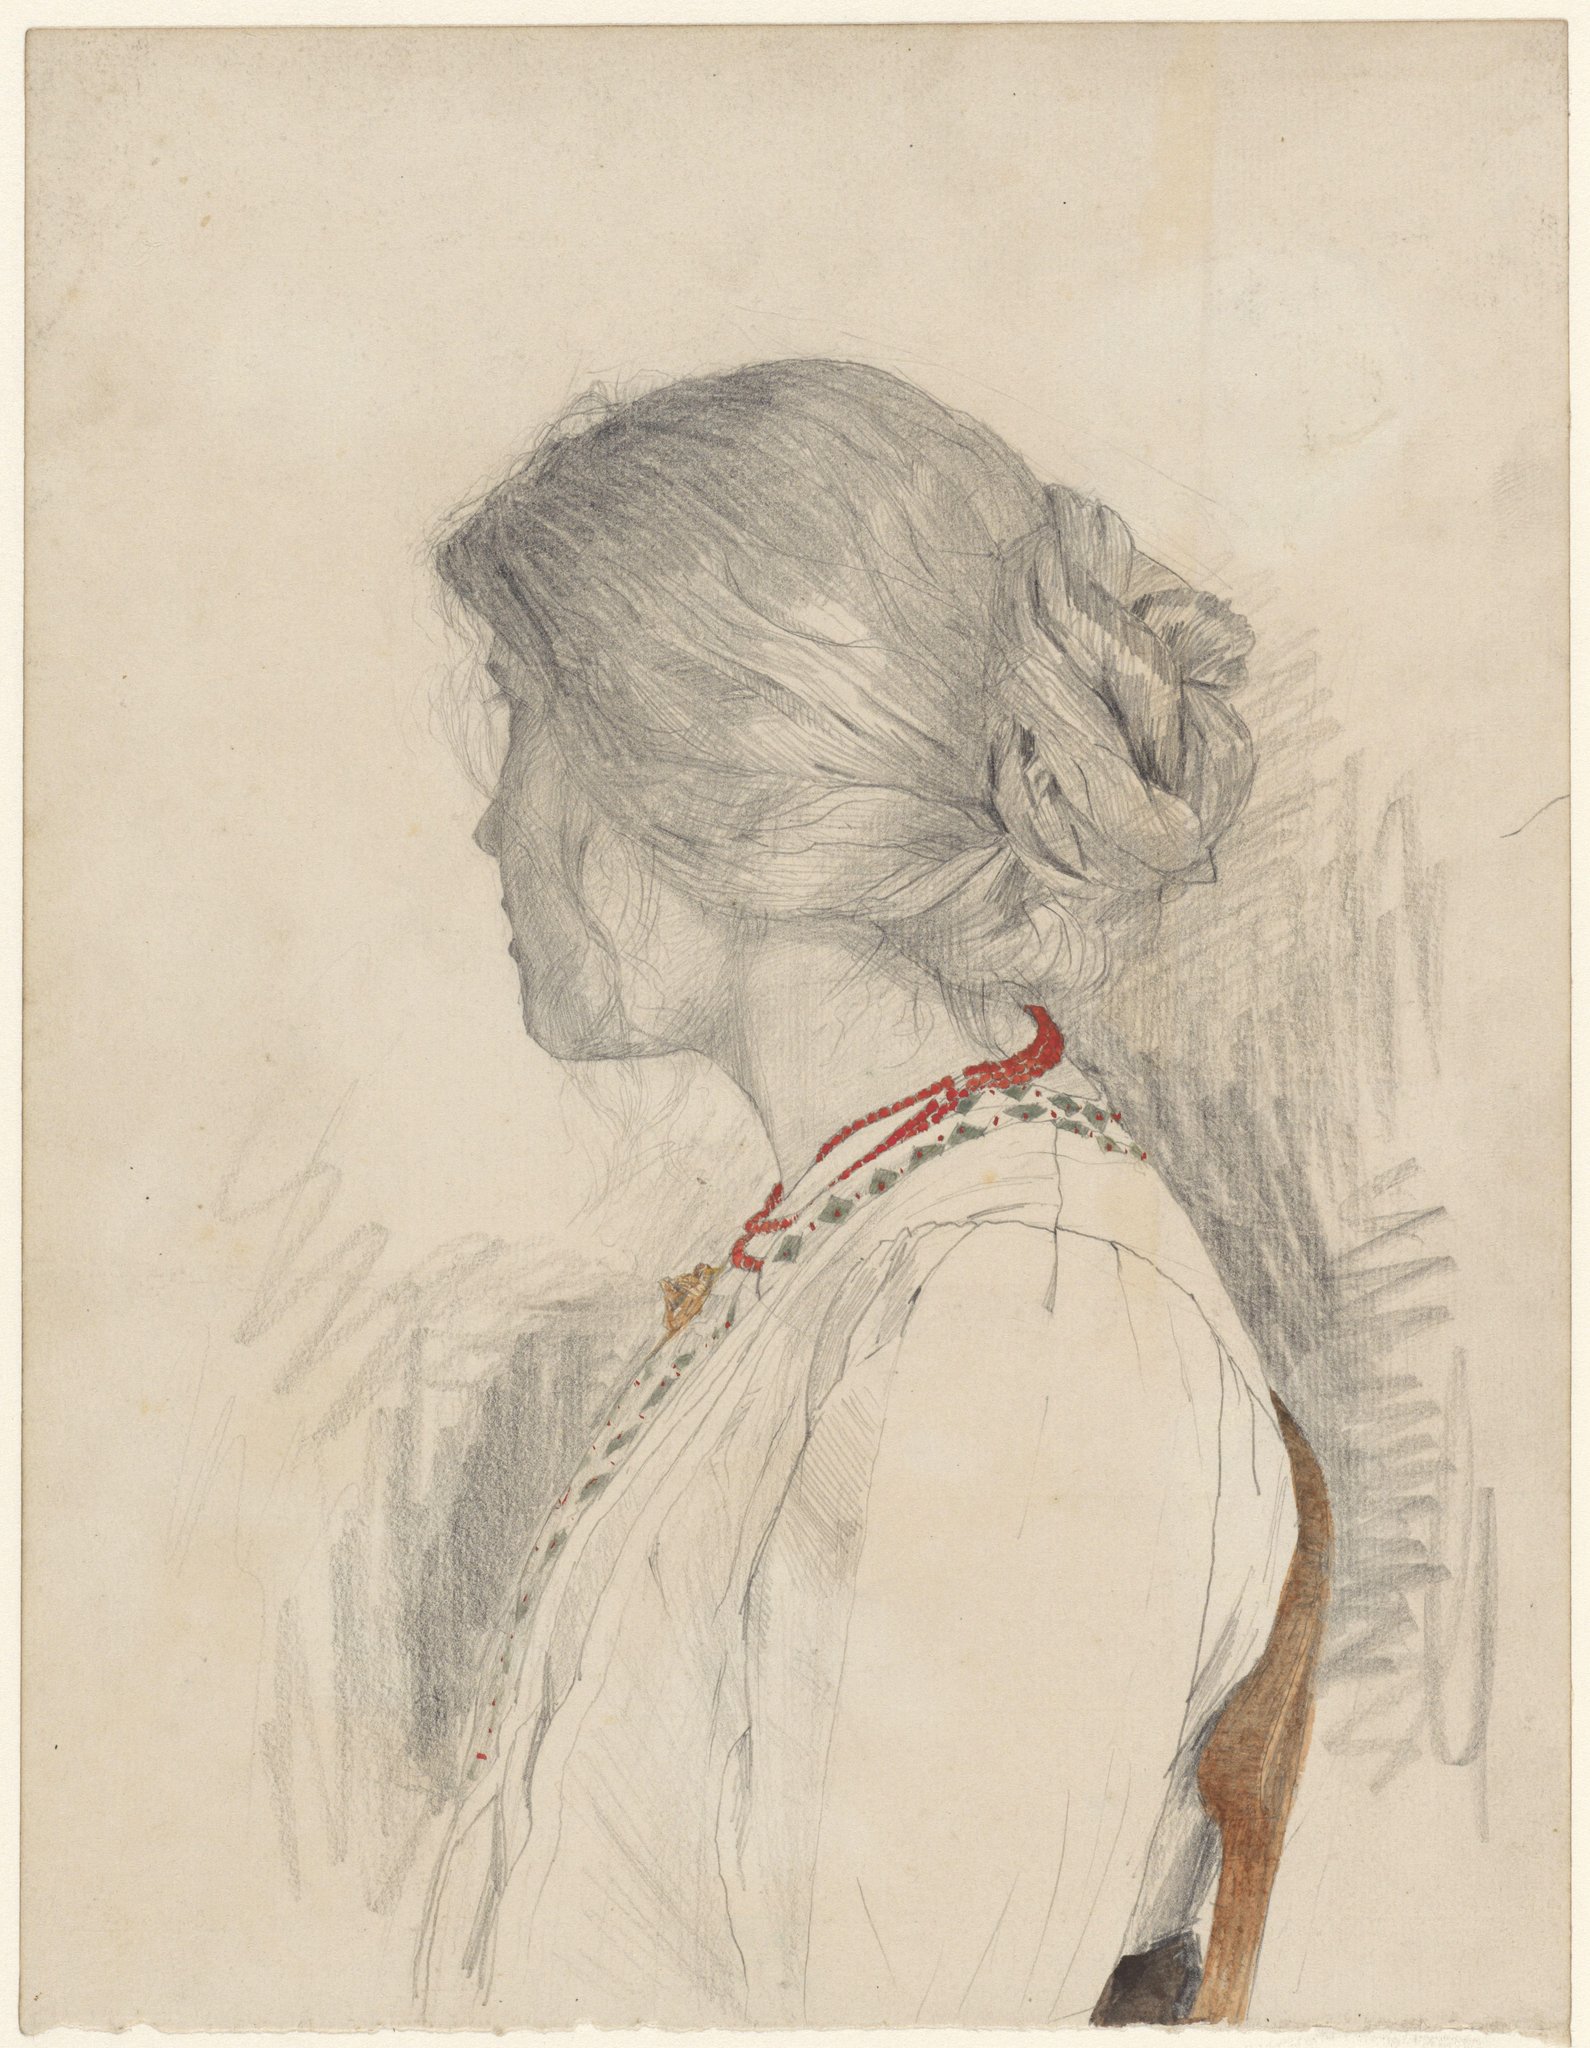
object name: drawing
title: Studie van een vrouw in een stoel, in profiel naar links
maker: theo nieuwenhuis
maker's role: designer, draughtsman, print maker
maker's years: 1866-1951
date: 1876-1951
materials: paper, pencil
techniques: brush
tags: anonymous historical person portrayed alone